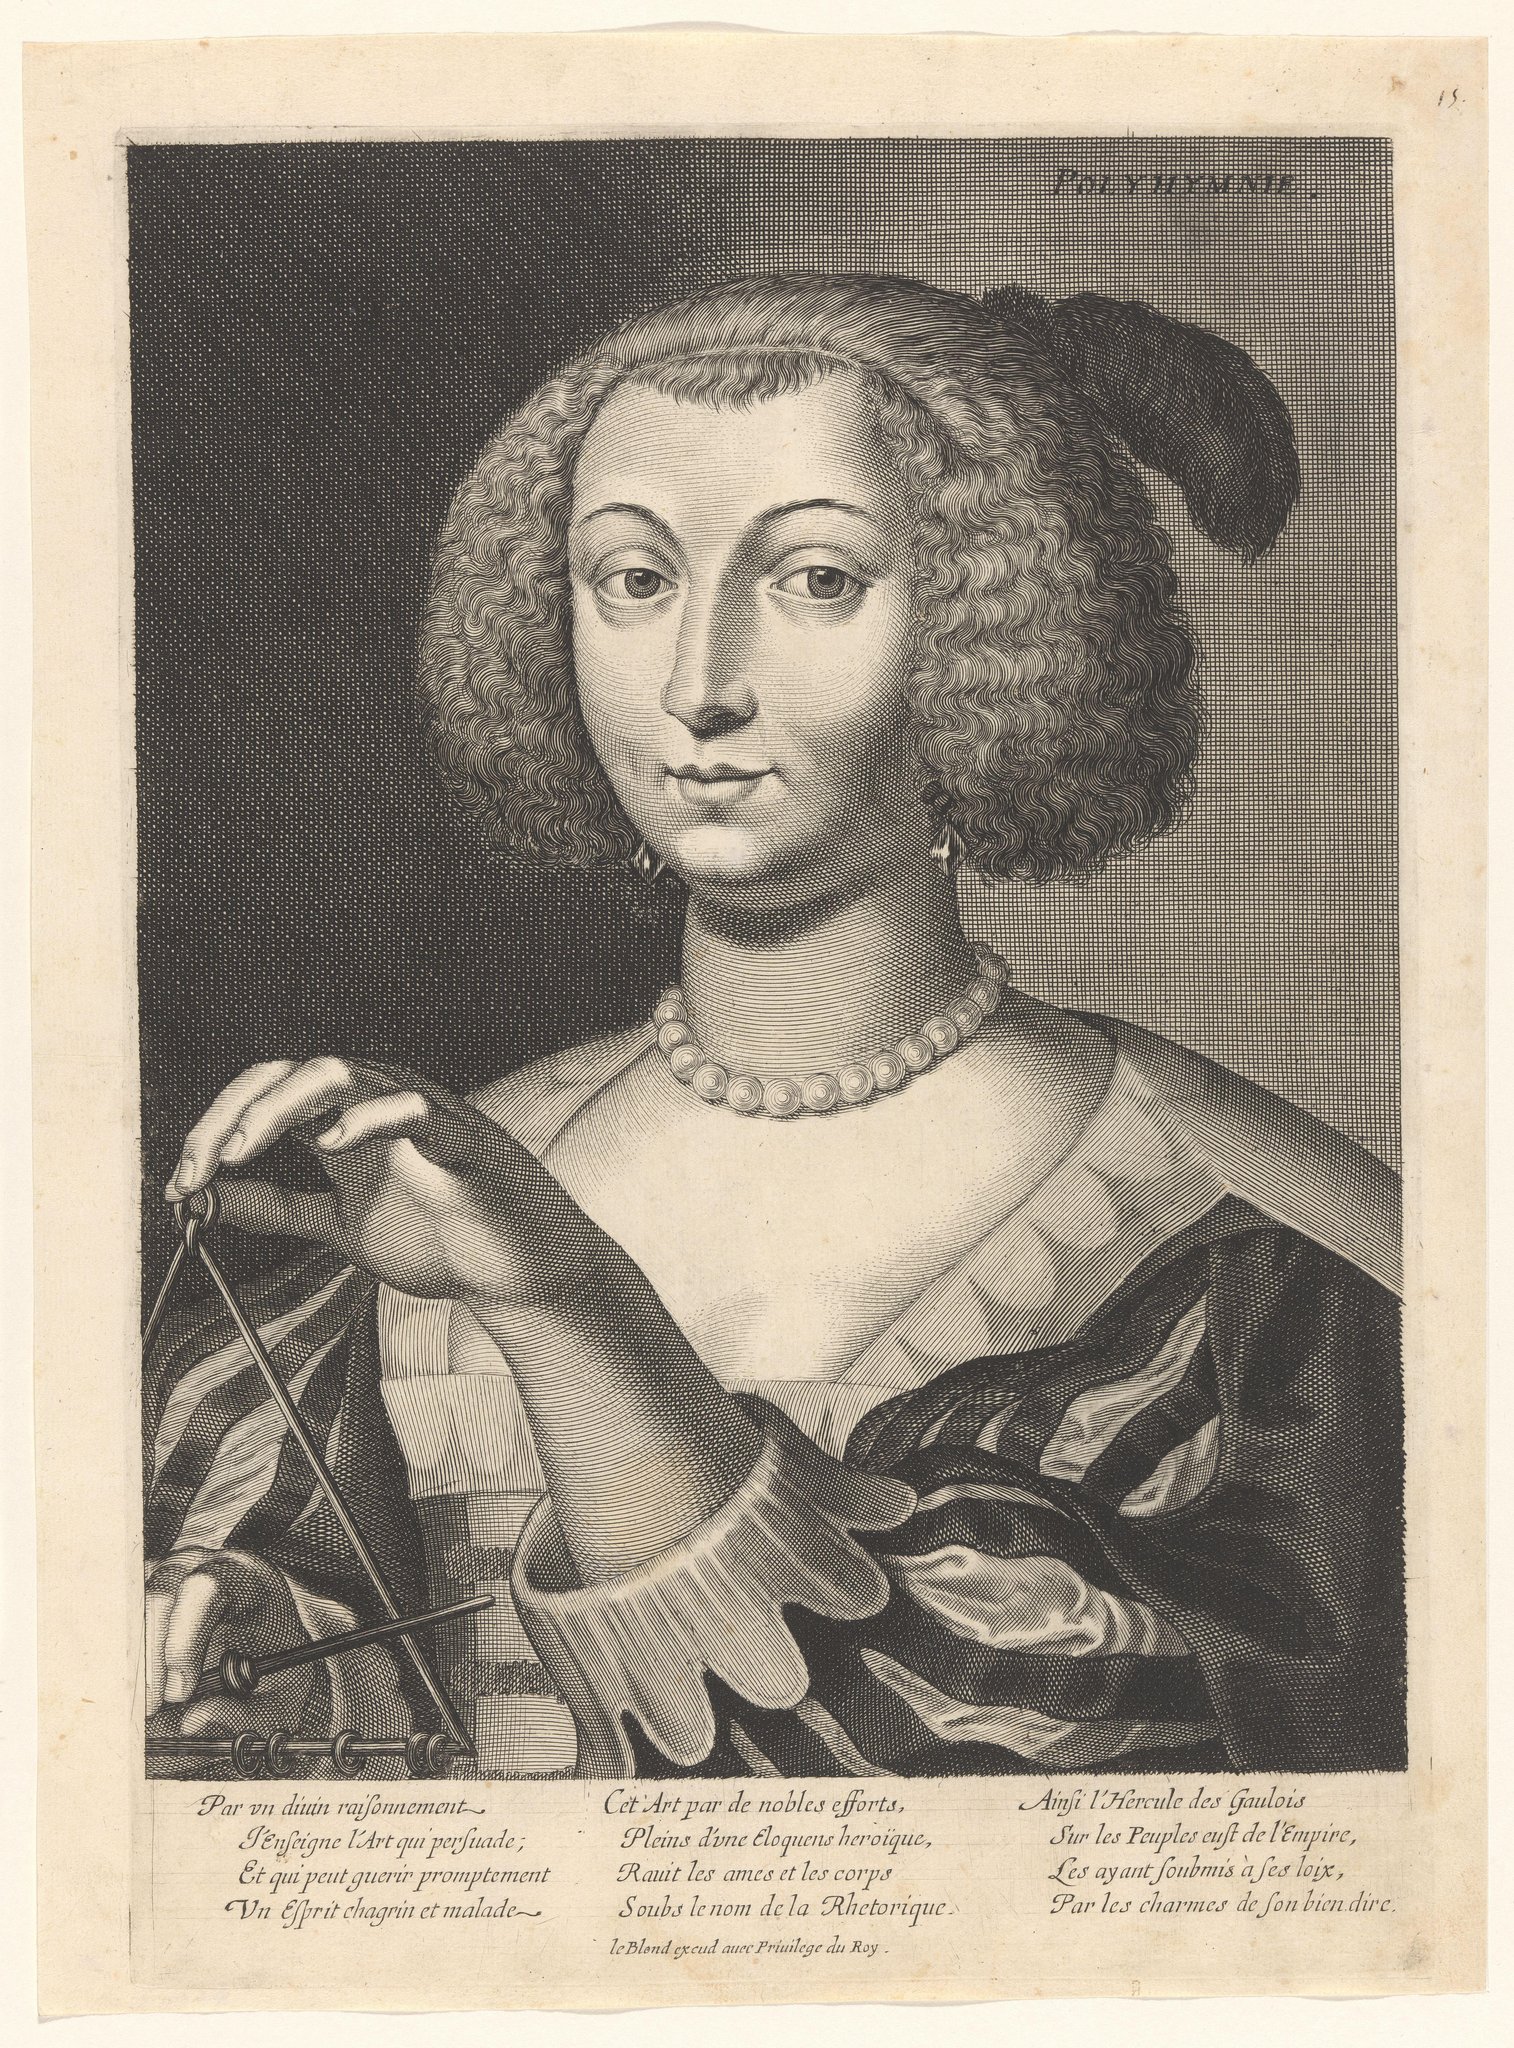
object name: print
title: Apollo and the Nine Muses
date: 1630-1635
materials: paper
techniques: engraving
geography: france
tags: one person playing percussion instrument, other percussion instruments (with name), polyhymnia (one of the muses); 'polinnia' (ripa)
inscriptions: collector's mark: Lugt 2760, number: ‘14’, collector's mark: Lugt 2228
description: While there are numerous depictions of Apollo and the nine muses, these ones are exceptional. In Greek mythology, Apollo is the god of music and harmony and his sisters, the muses, are the goddesses of art and science and symbols of inspiration. Le Blond portrayed each of them separately, making music. Dressed and coiffed according to the latest Parisian fashion around 1630, they have thus become contemporary.